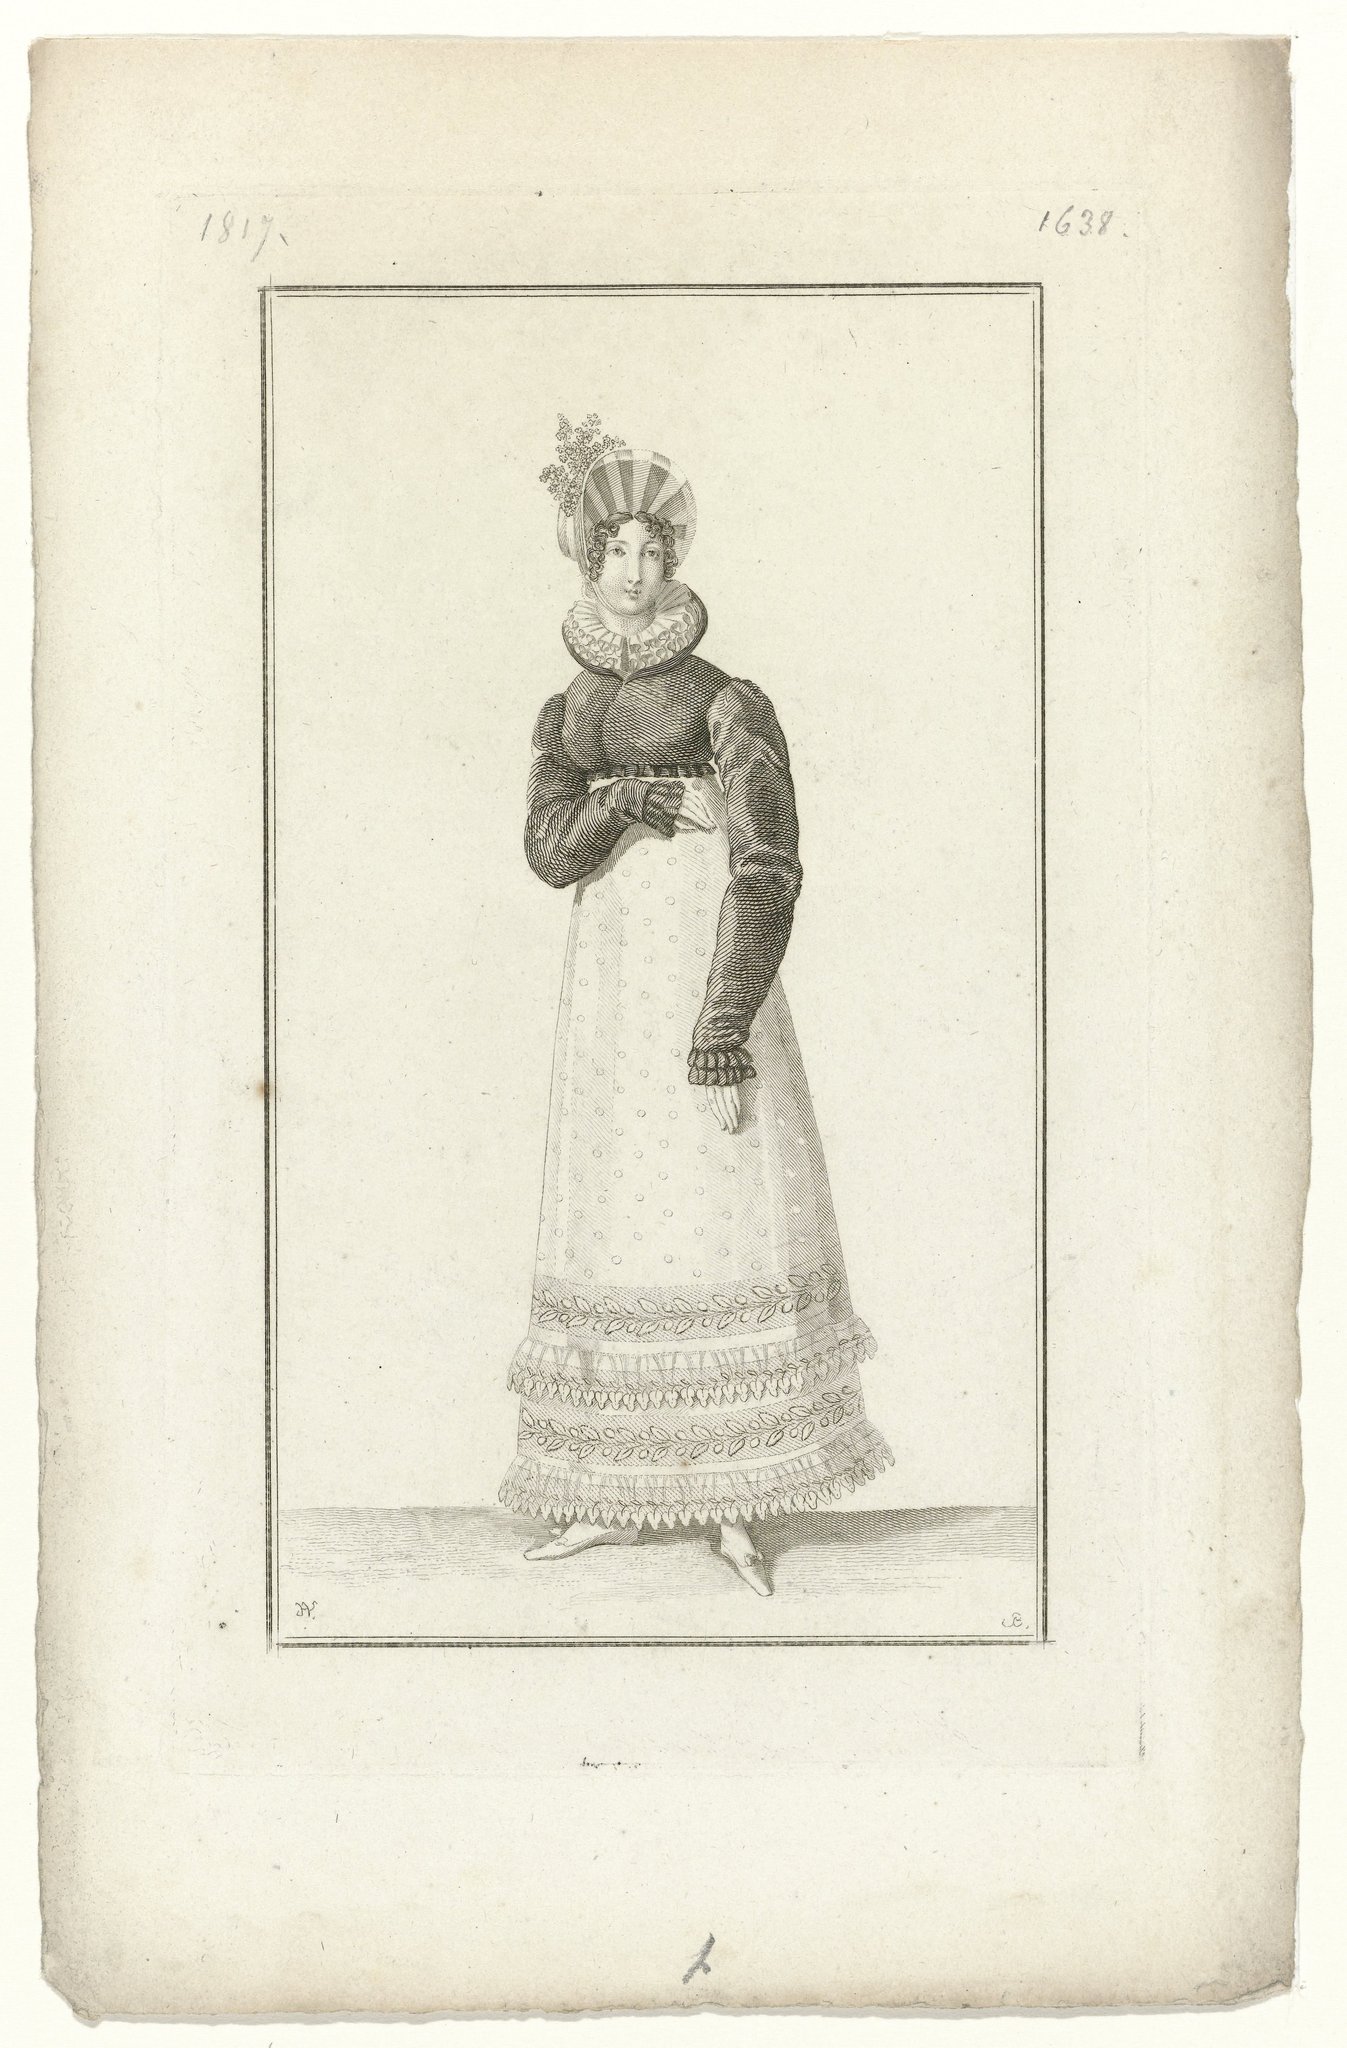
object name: fashion print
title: Journal des Dames et des Modes, Costume Parisien, 5 avril 1817 (1638)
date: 1817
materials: paper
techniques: engraving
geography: paris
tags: border, ribbon, braid (+ women's clothes), clothing for the upper part of the body (spencer) (+ women's clothes), fashion plates, head-gear: hat (+ women's clothes), shoes, sandals (+ women's clothes), neck-gear ~ clothing (with name) (+ women's clothes), dress, gown (+ women's clothes)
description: Staande vrouw gekleed in een spencer van fluweel op een japon met stippenmotief, bij de zoom versierd met een bladmotief. Dubbel geplooide kraag. Op het hoofd een gestreepte luifelhoed met opgenaaide linten. platte schoenen met vierkante neuzen en strikken. Proefdruk van een prent uit het modetijdschrift Journal des Dames et des Modes, uitgegeven door Pierre de la Mésangère, Parijs, 1797-1839.